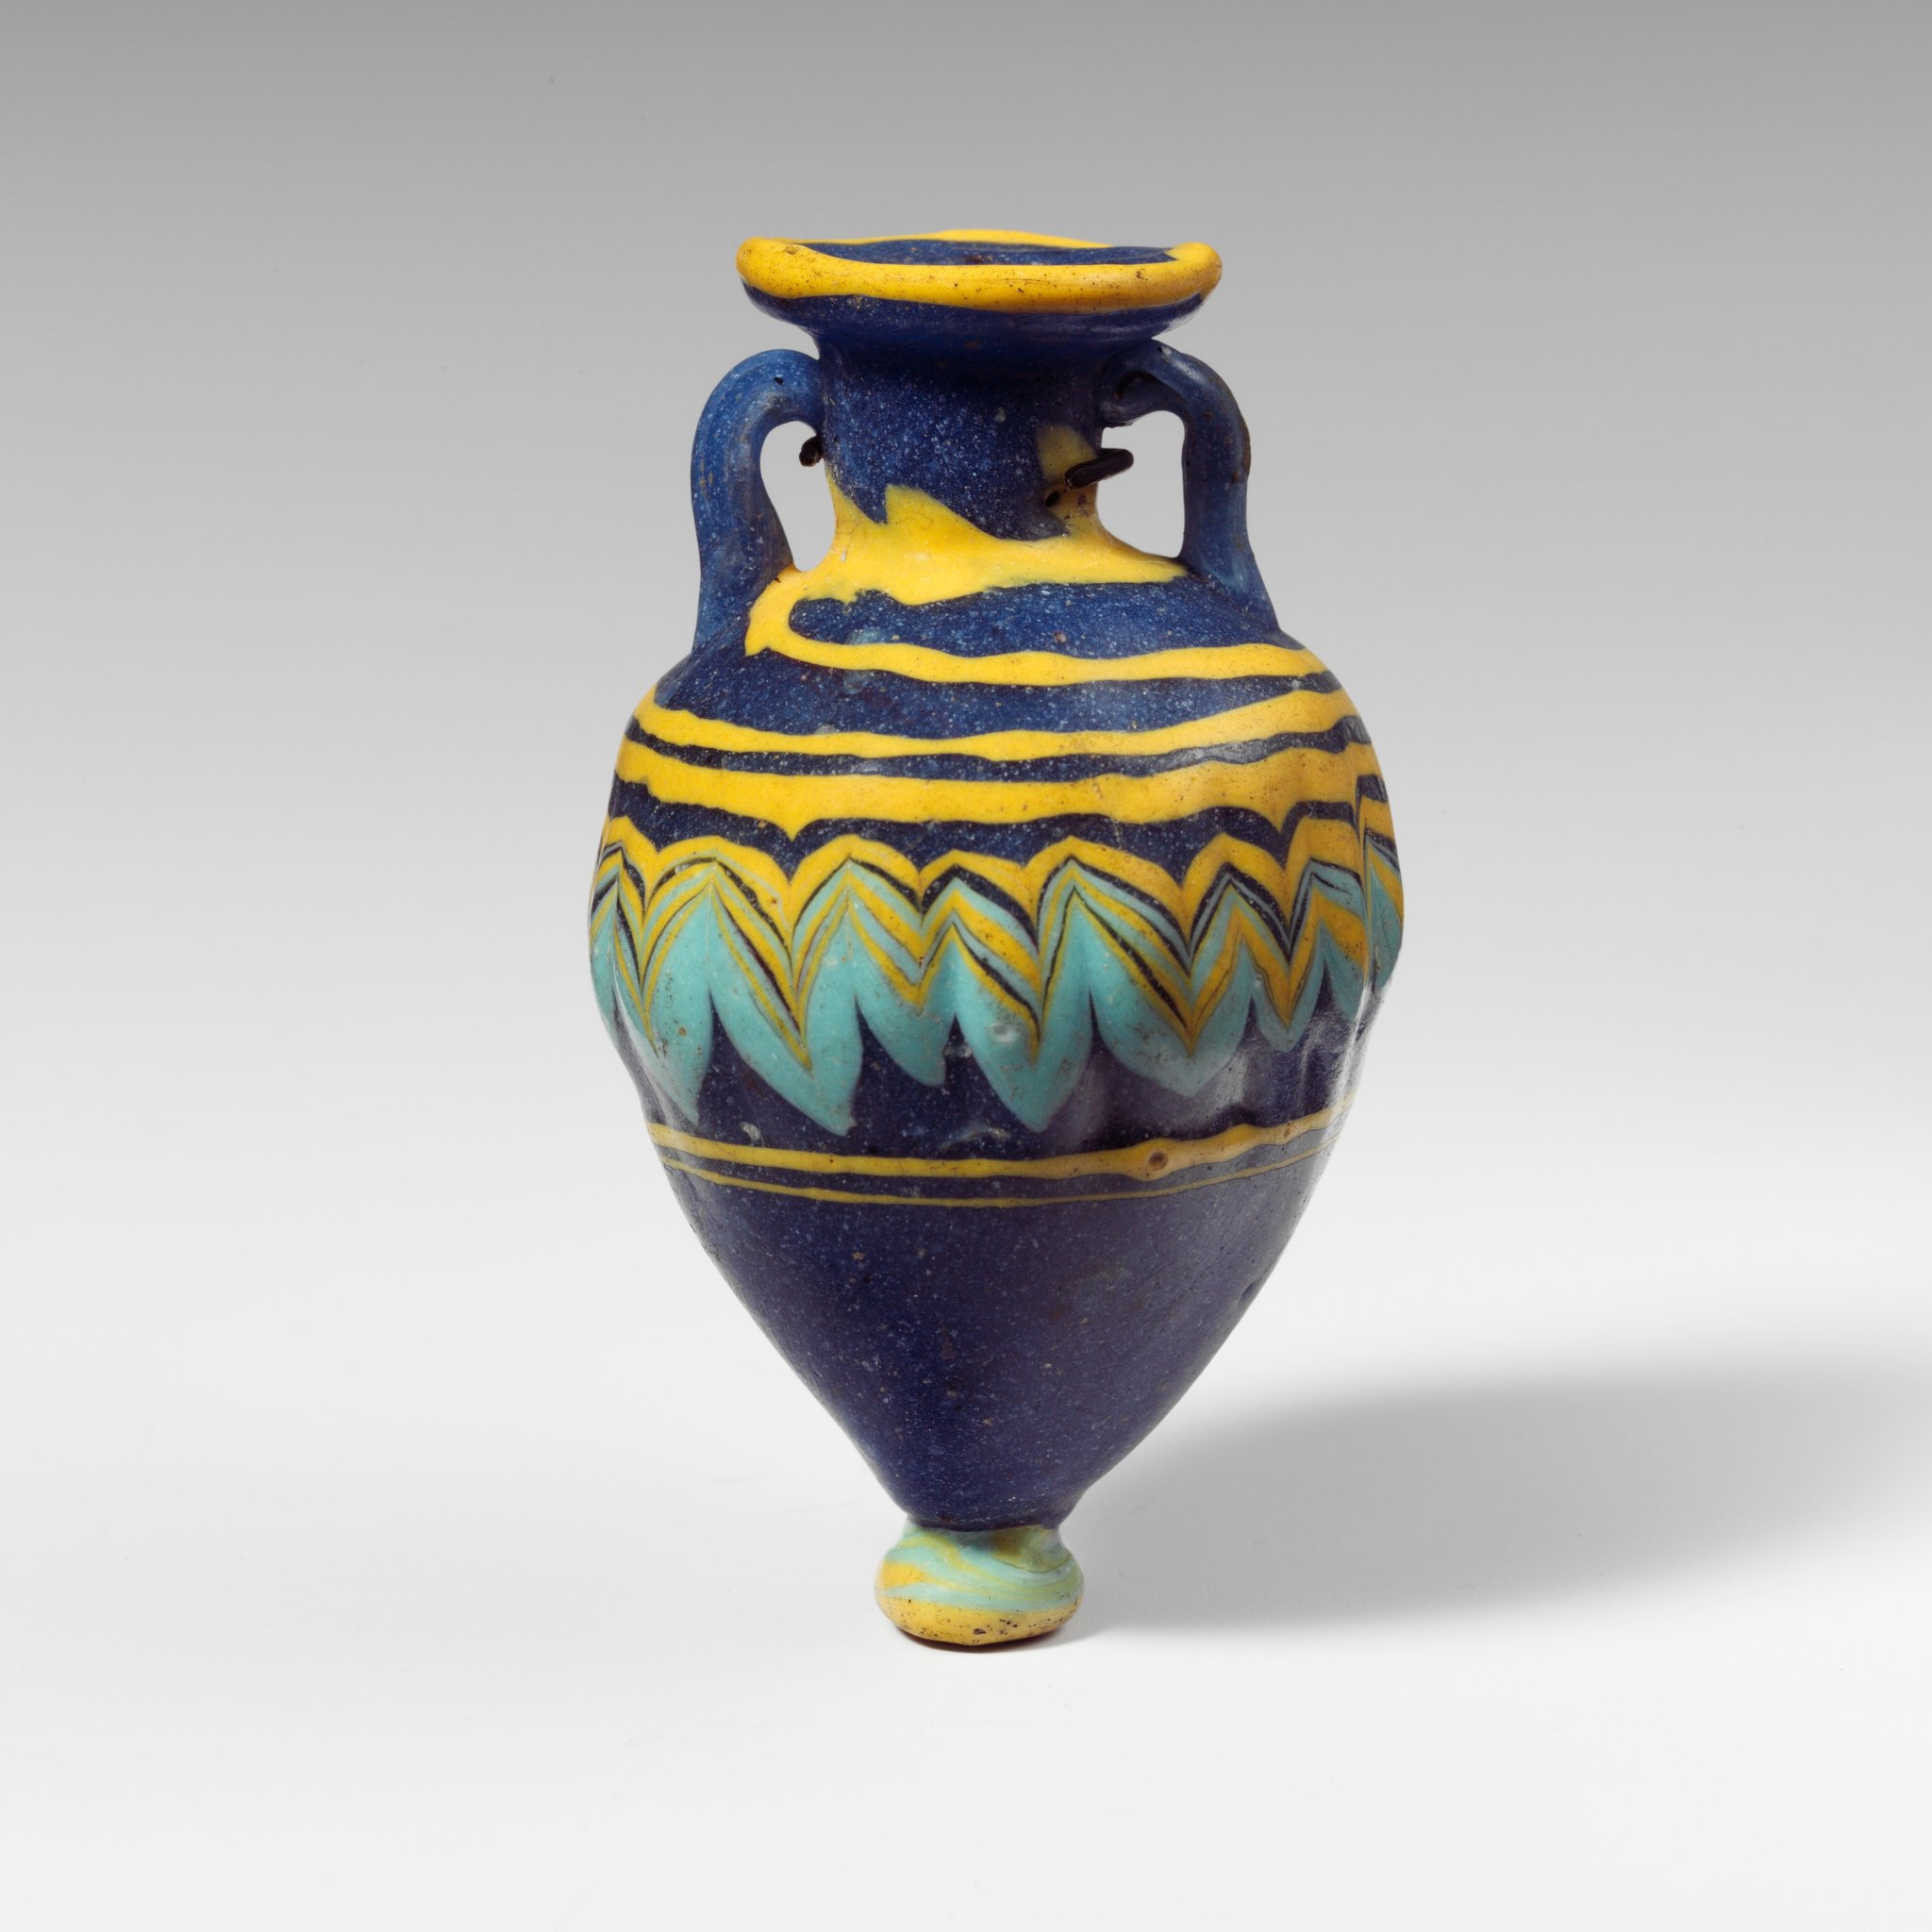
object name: amphoriskos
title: Glass amphoriskos (perfume bottle)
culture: greek, eastern mediterranean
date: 534-401 BCE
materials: glass